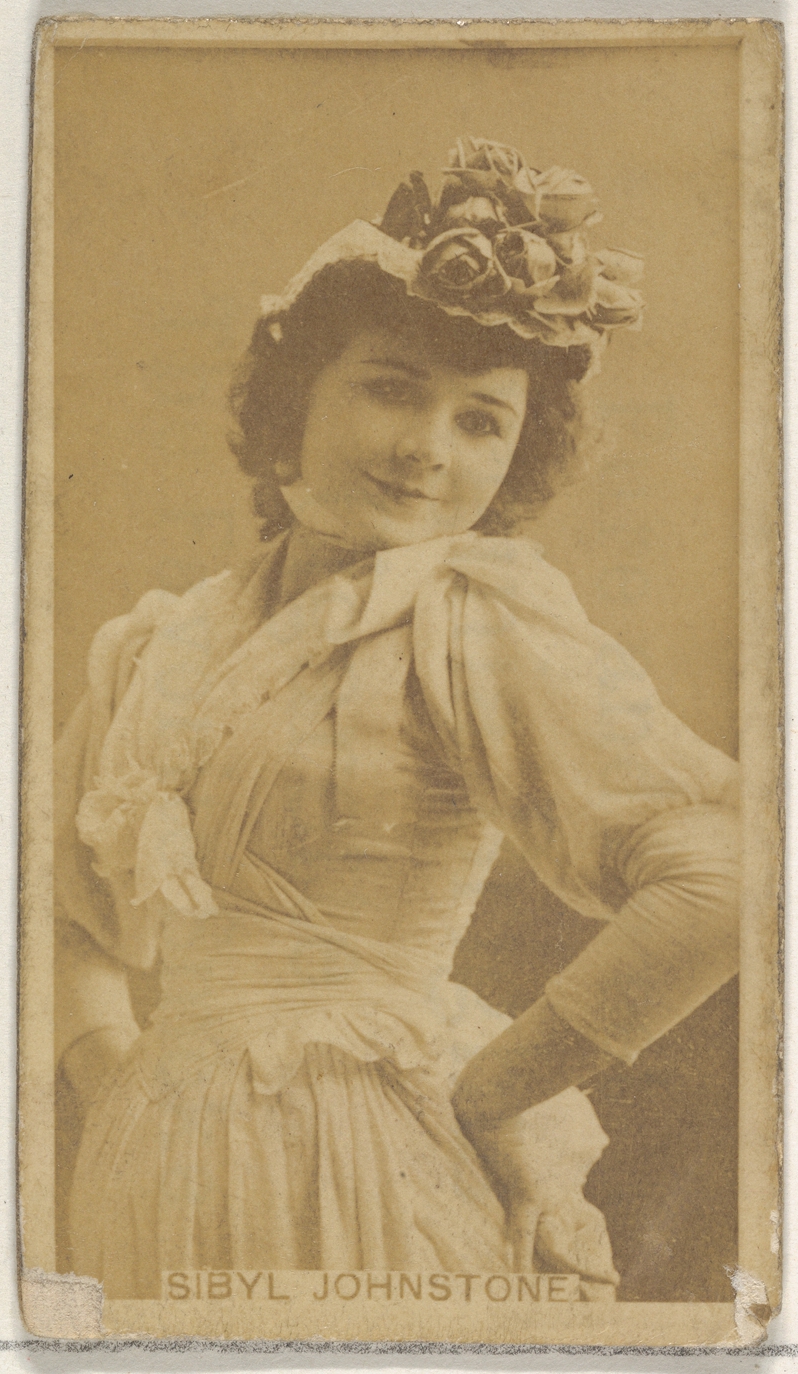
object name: photograph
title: Sibyl Johnstone, from the Actors and Actresses series (N45, Type 8) for Virginia Brights Cigarettes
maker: allen & ginter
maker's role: publisher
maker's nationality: american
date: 1888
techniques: albumen silver print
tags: portraits,women,actresses